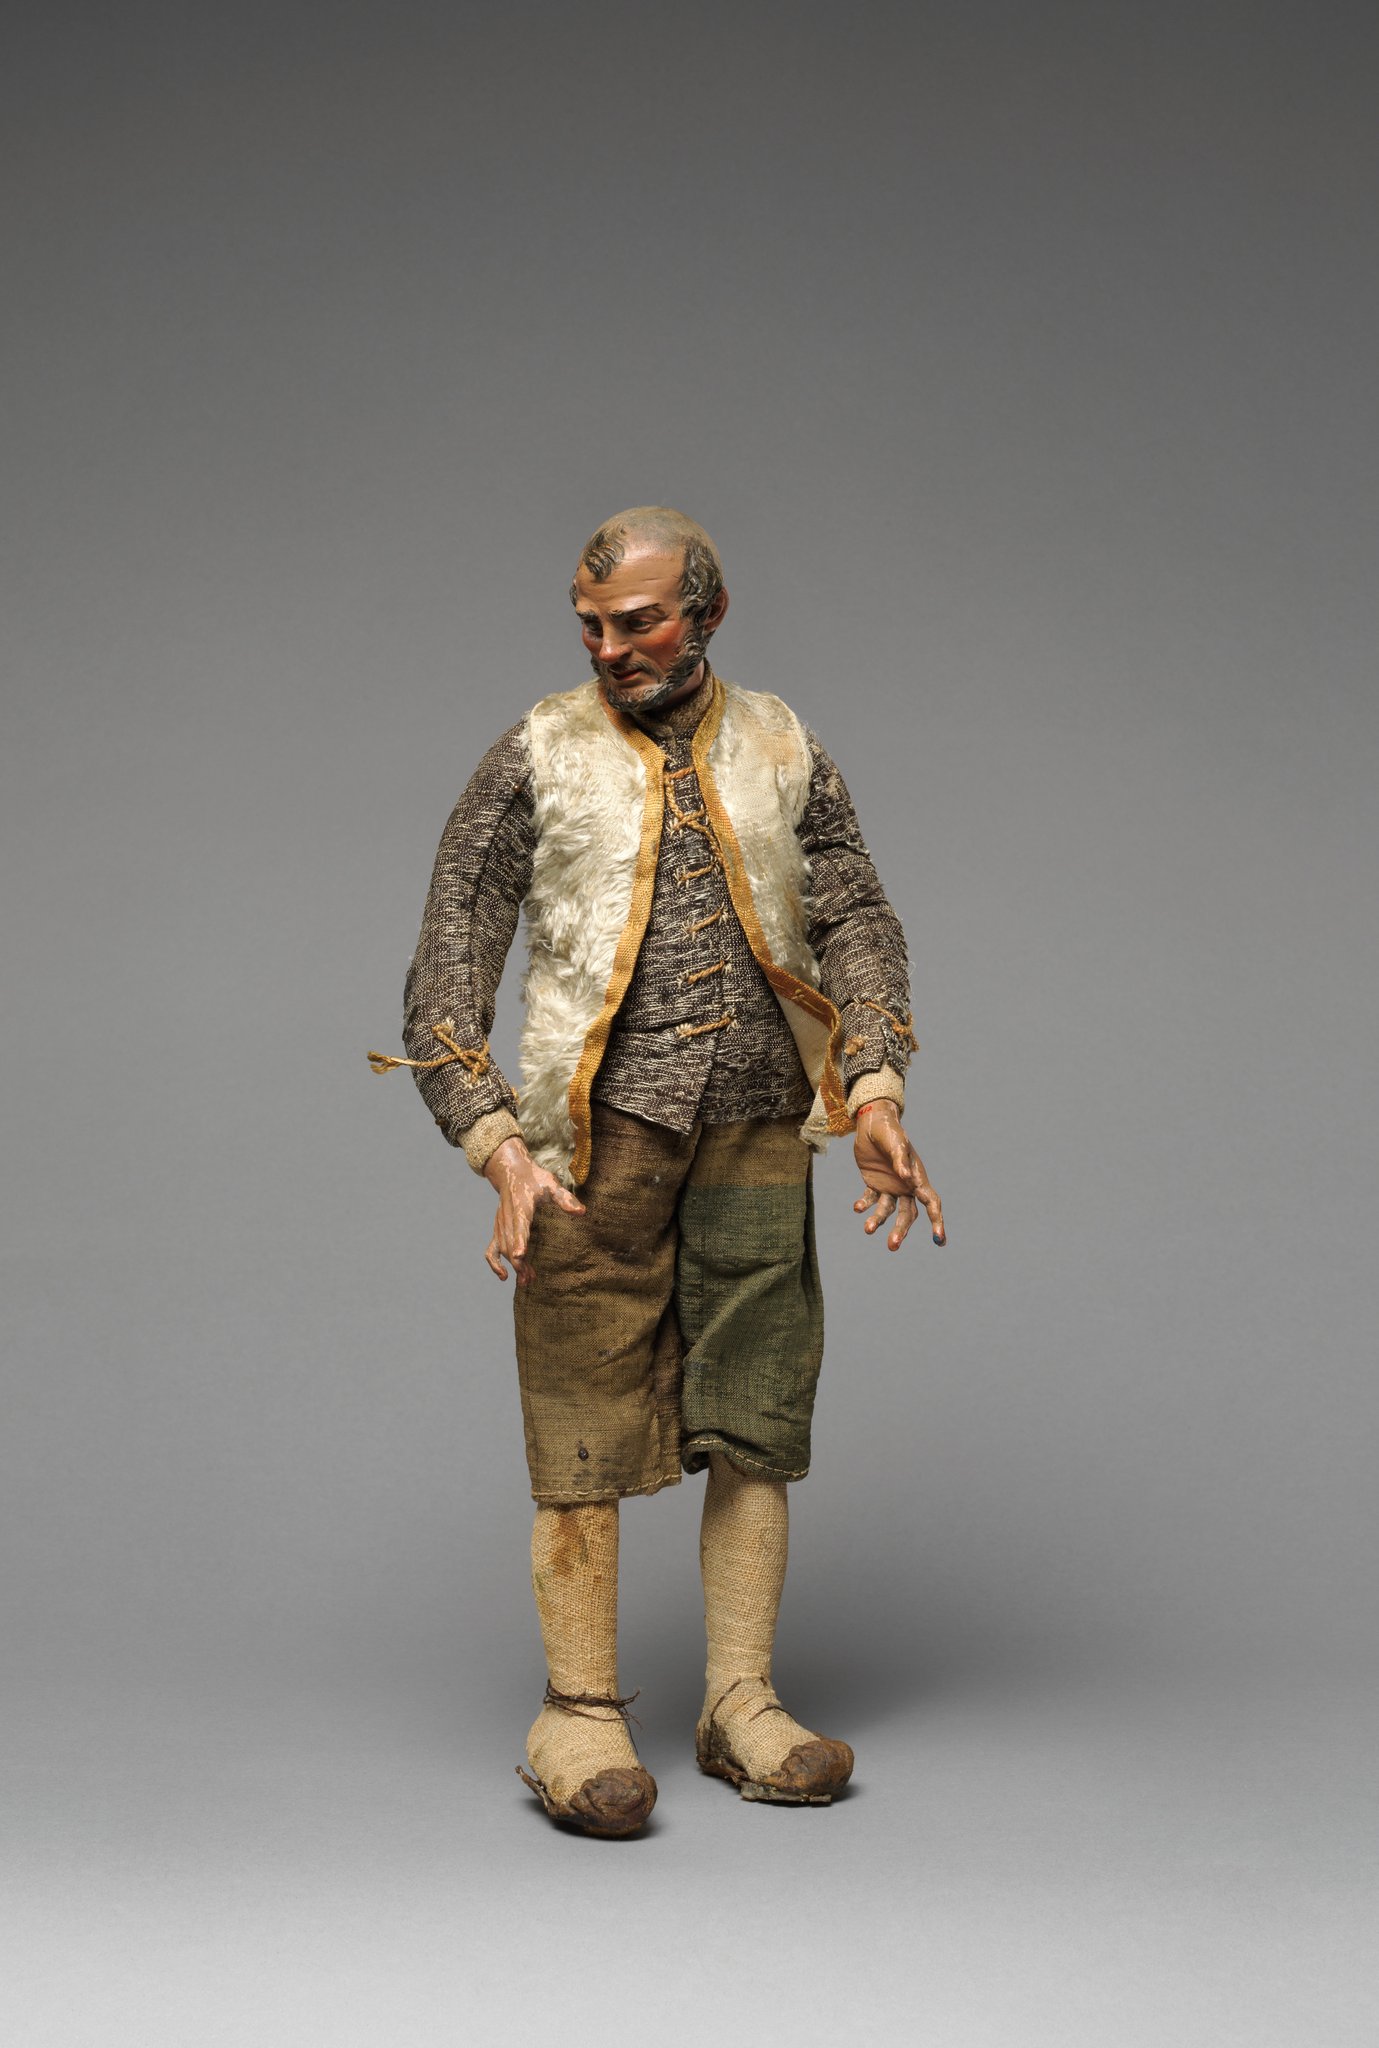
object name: crèche figure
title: Bearded “Innkeeper” with white furry vest, black/white shirt, brown knickers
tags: men